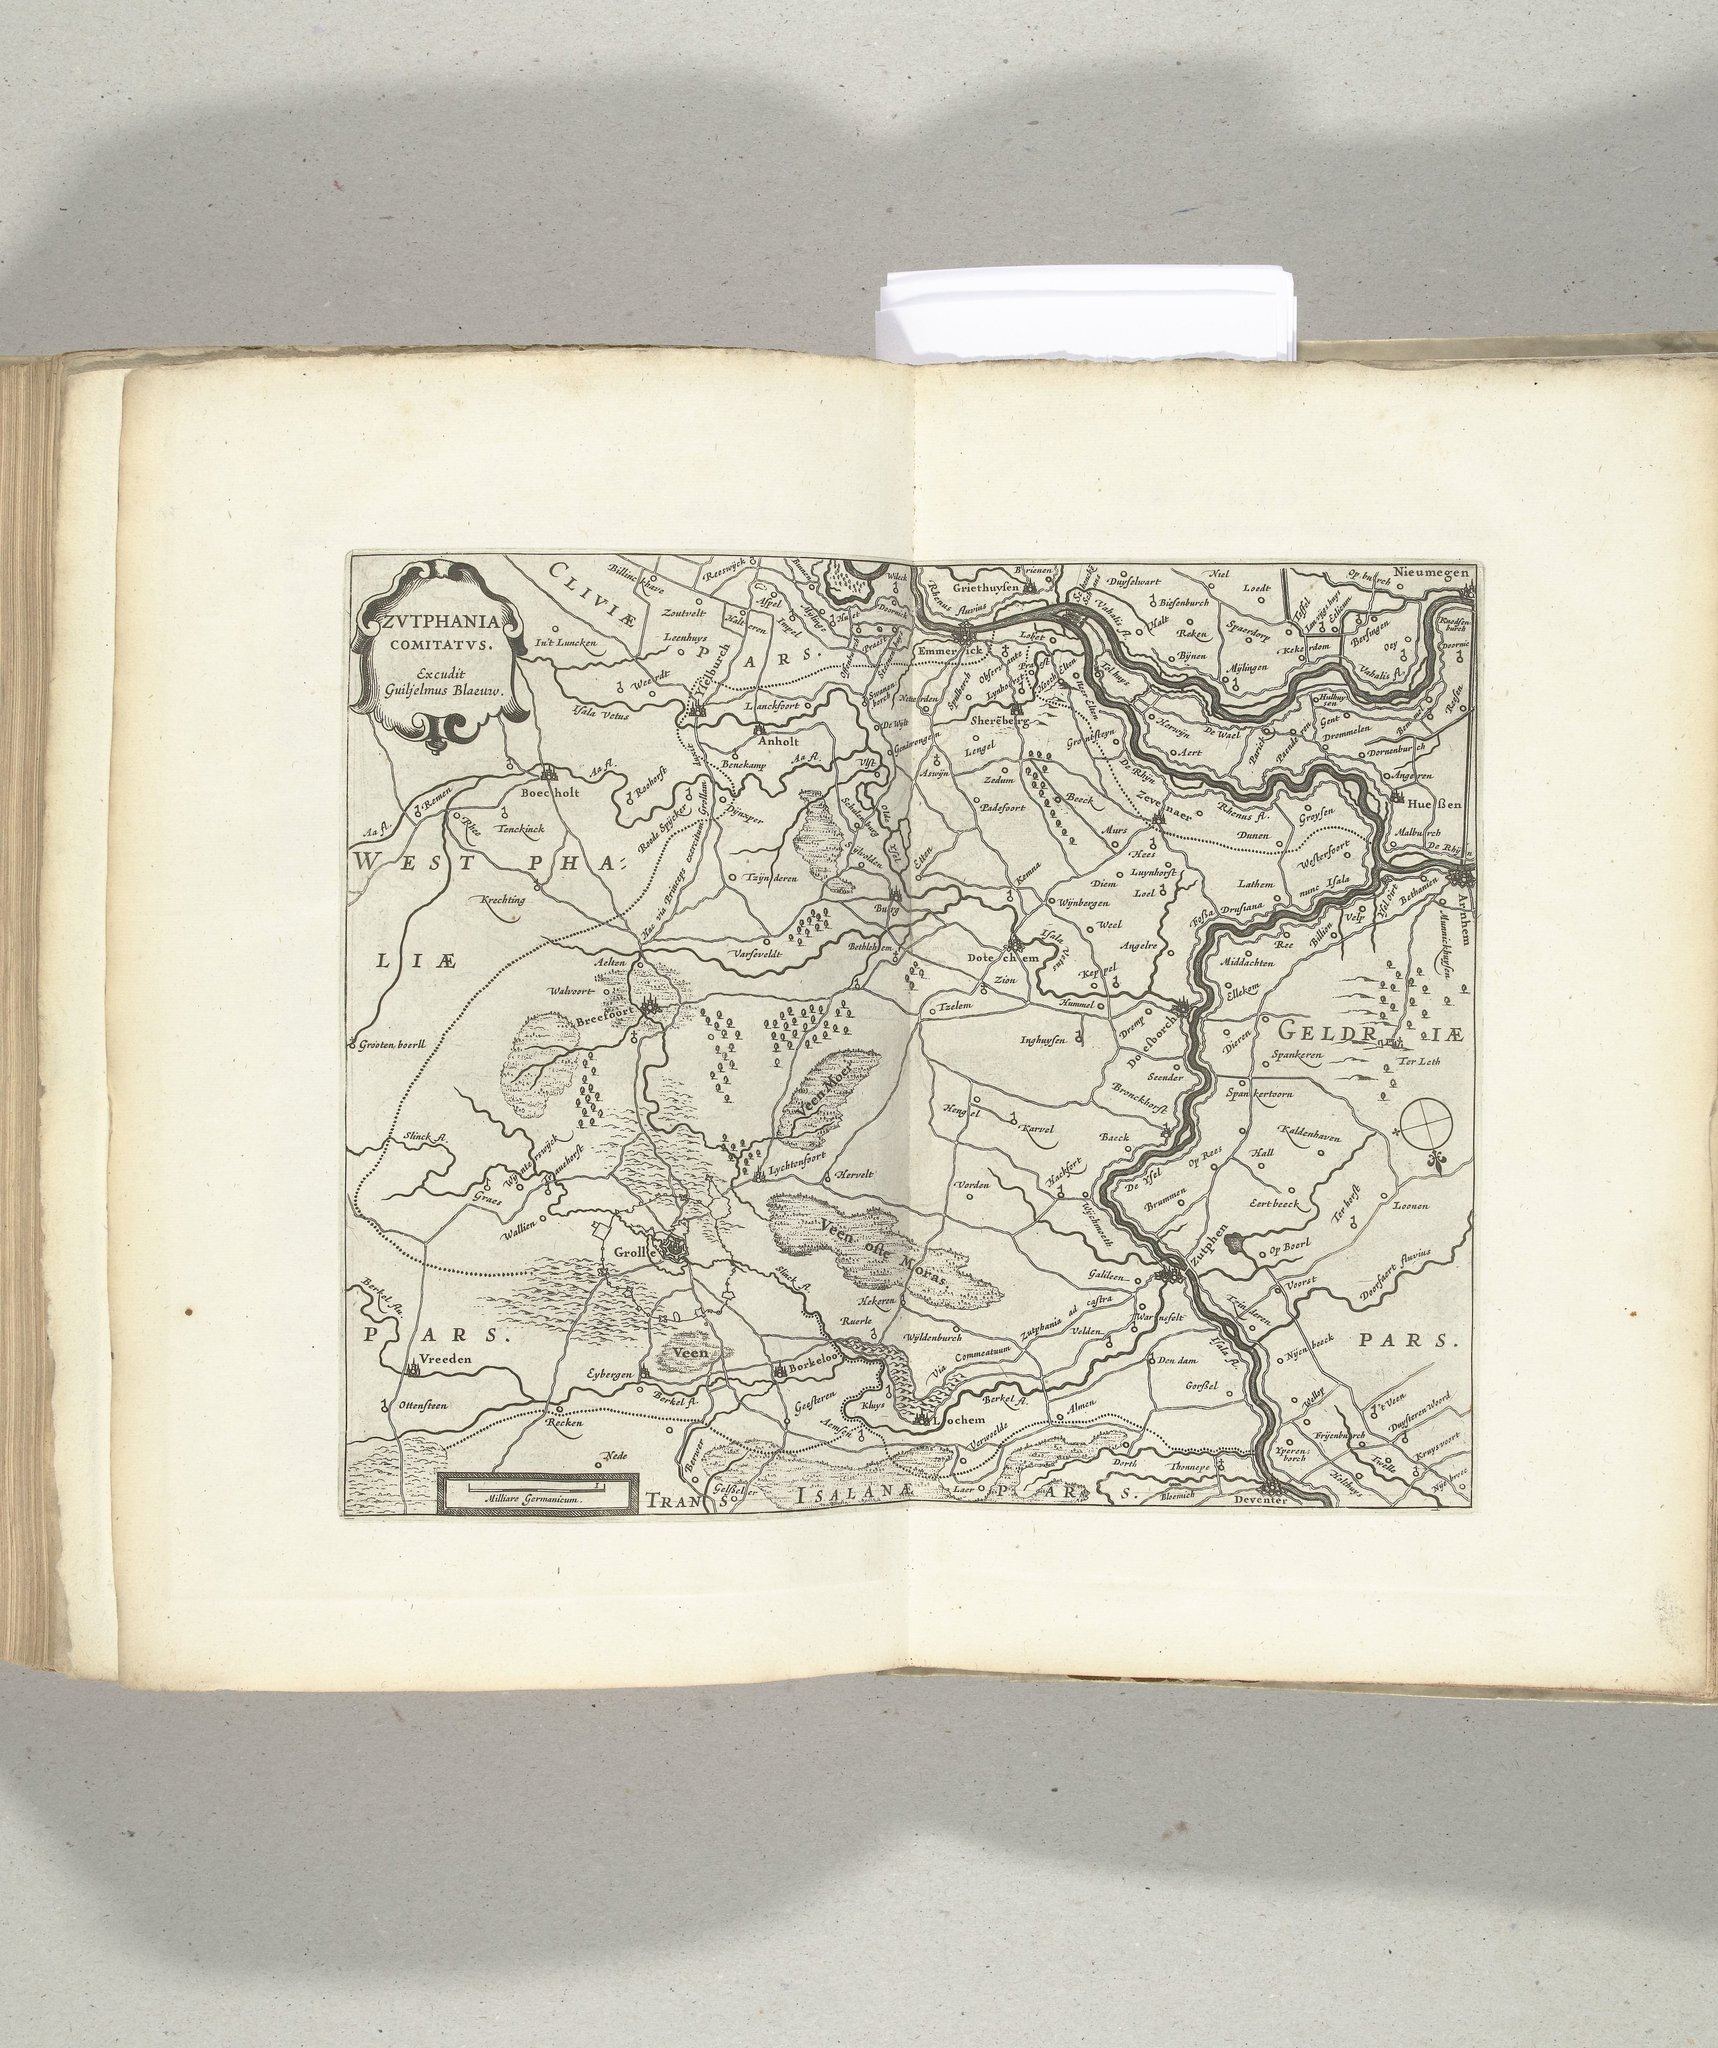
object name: map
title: Zutphania Comitatus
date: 1627-1629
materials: paper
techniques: etching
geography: amsterdam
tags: frederick henry (prince of orange), maps of separate countries or regions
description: Kaart van het graafschap Zutphen, 1627. Linksonder de schaal, linksboven een cartouche met de titel, alles in het Latijn. Onderdeel van de platen bij het verslag van het beleg en de verovering van Grol door het Staatse Leger onder Frederik Hendrik, 6 juli tot 19 augustus 1627.